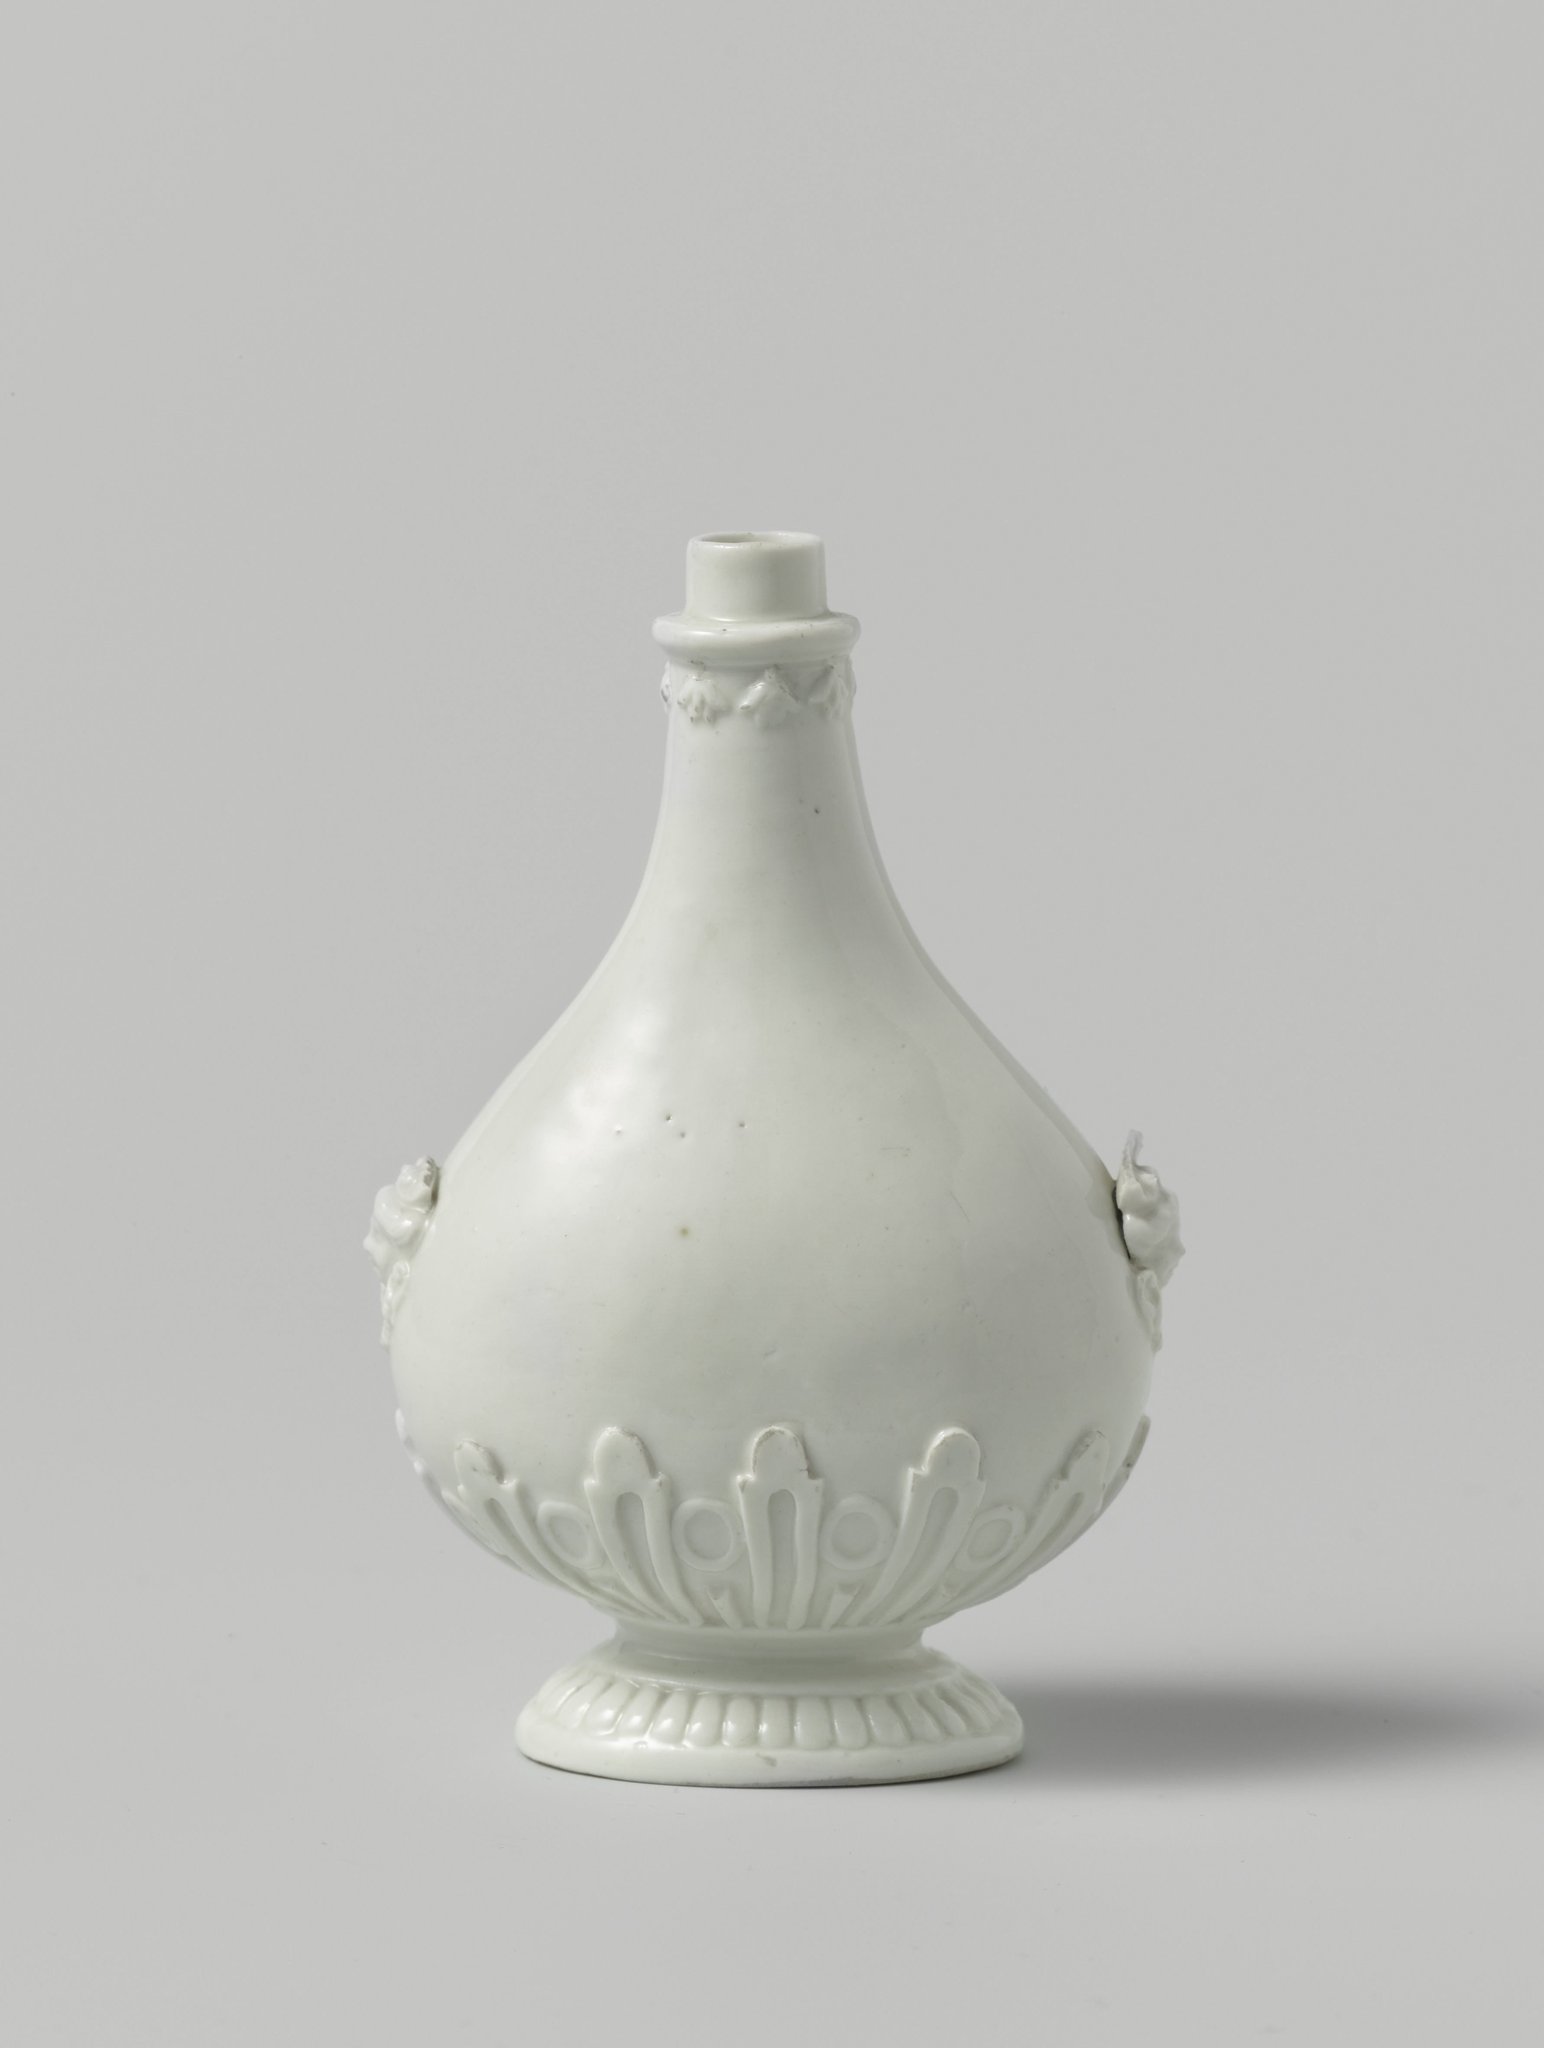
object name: flacon, flakon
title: Flask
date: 1715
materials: porcelain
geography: meissen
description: Meissener Porzellan Manufaktur Meissen, c. 1715 hard-paste porcelain